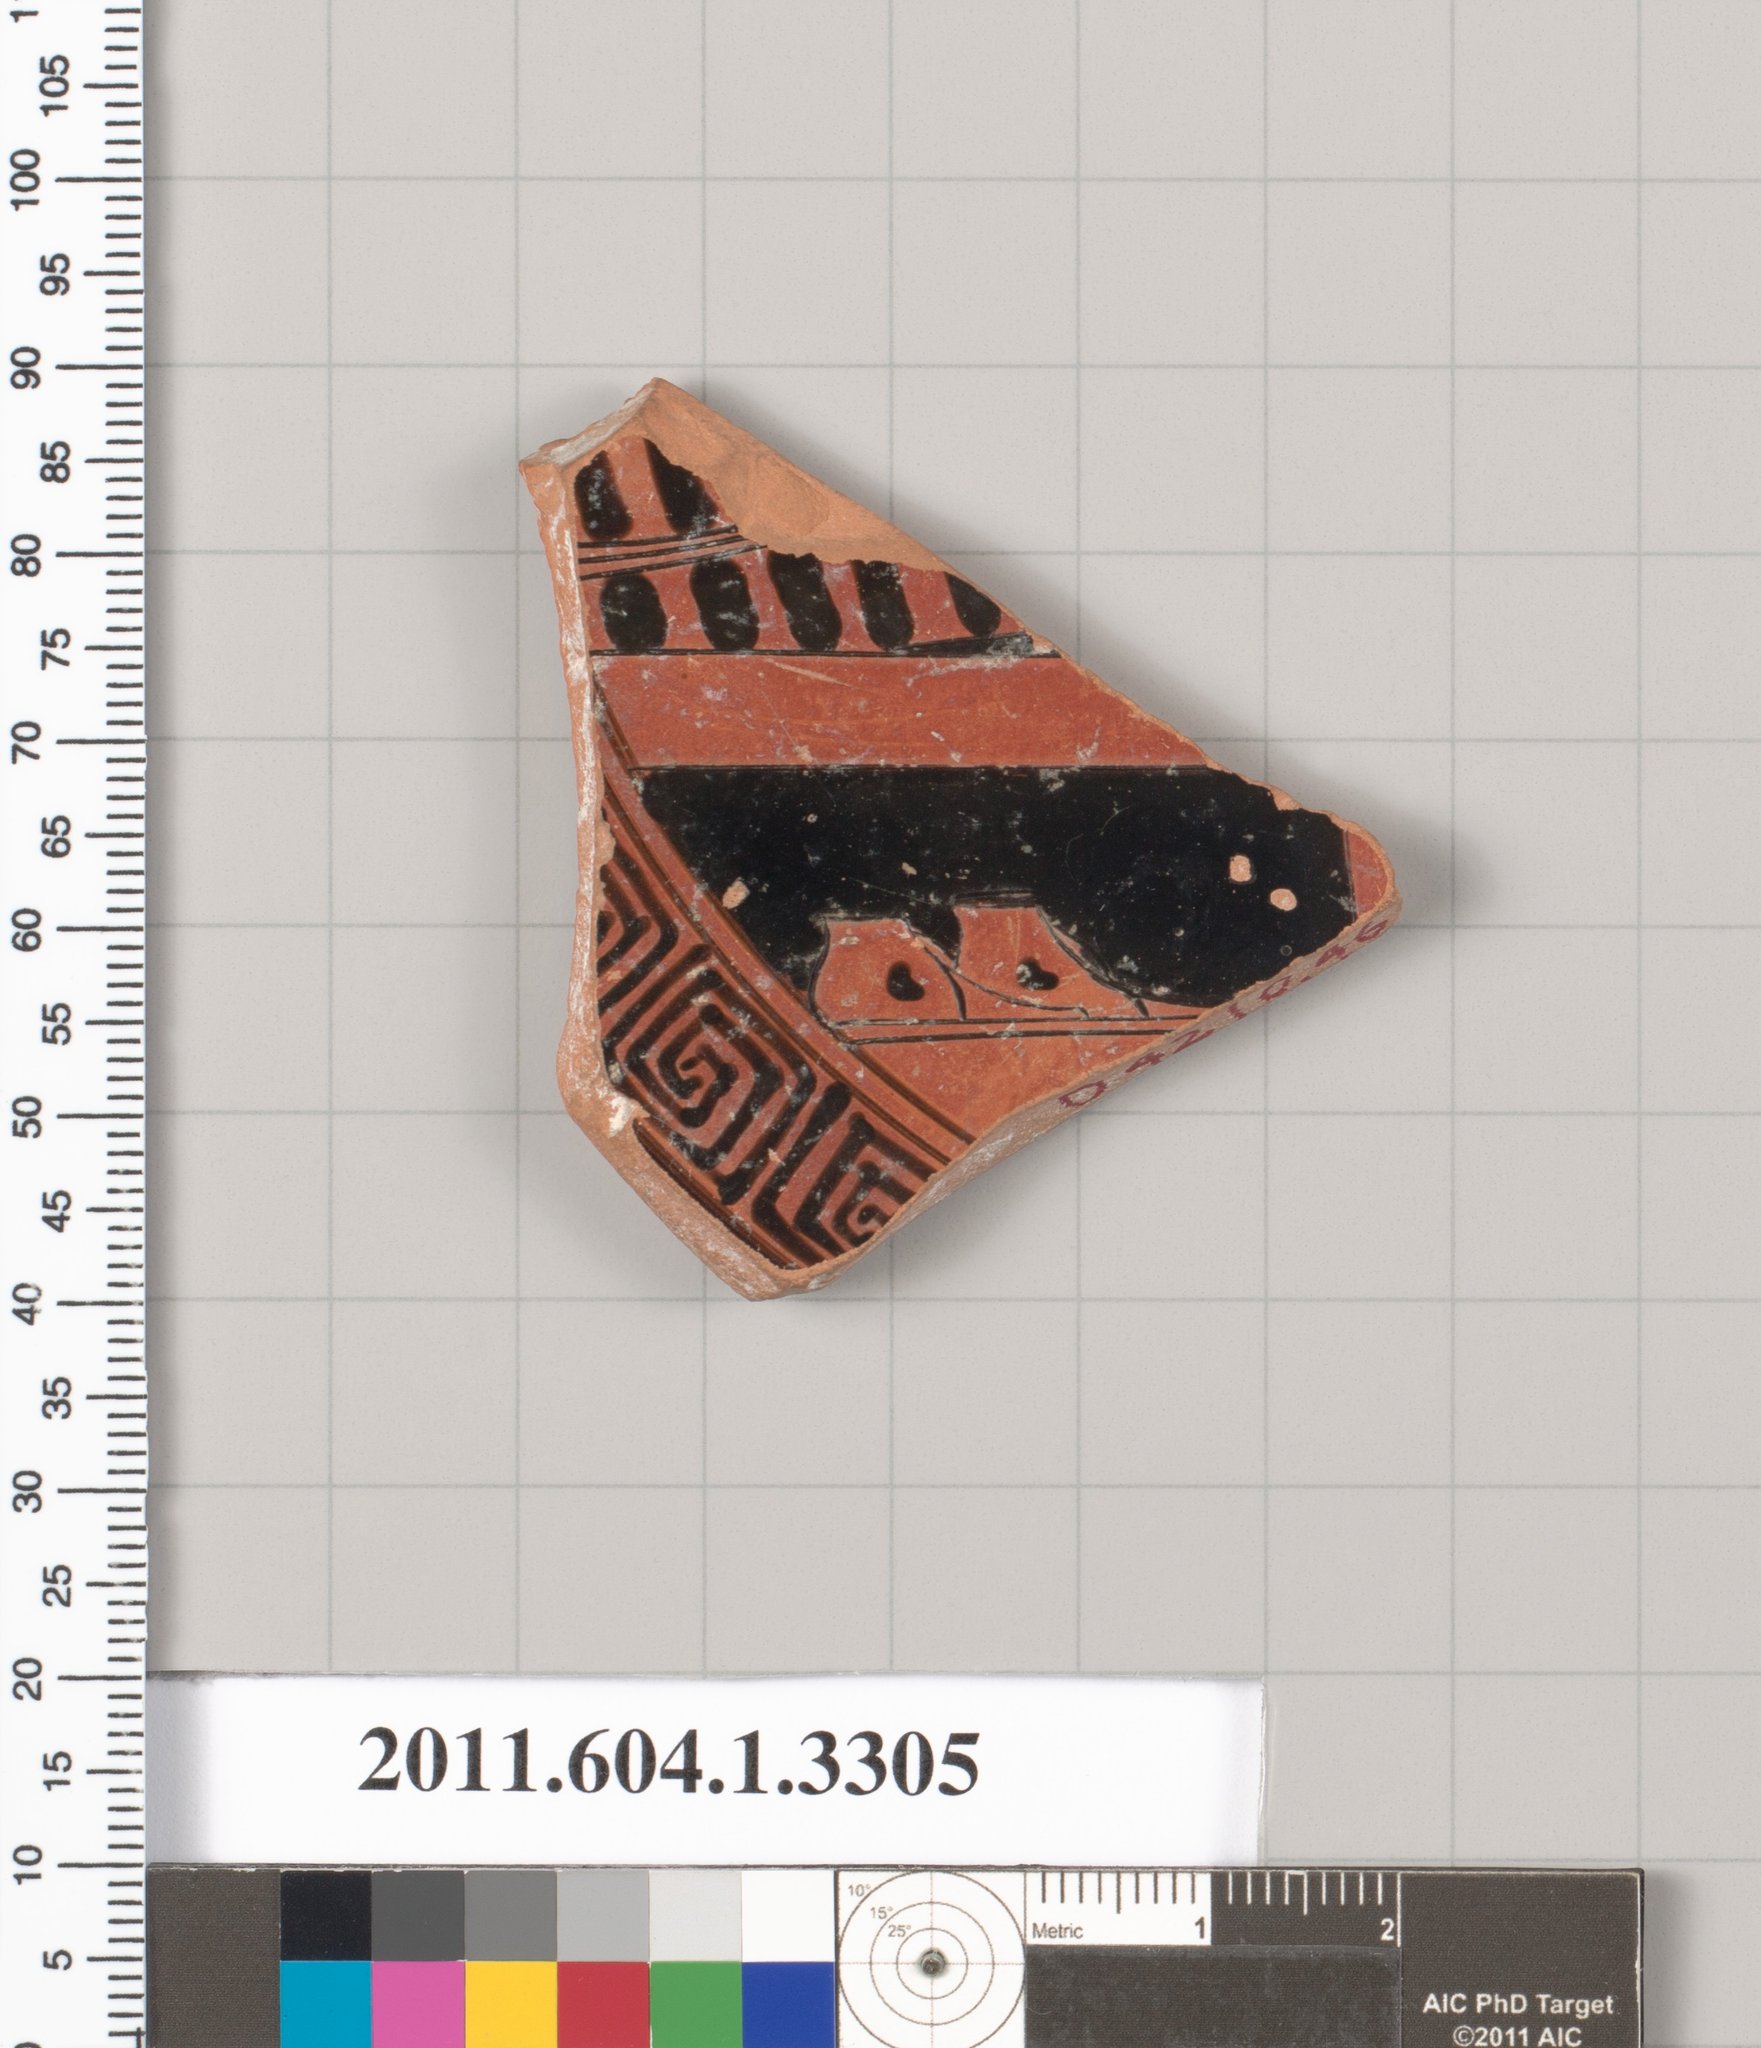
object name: kylix fragment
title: Terracotta fragment of a kylix (drinking cup)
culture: greek, attic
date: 475-451 BCE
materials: terracotta